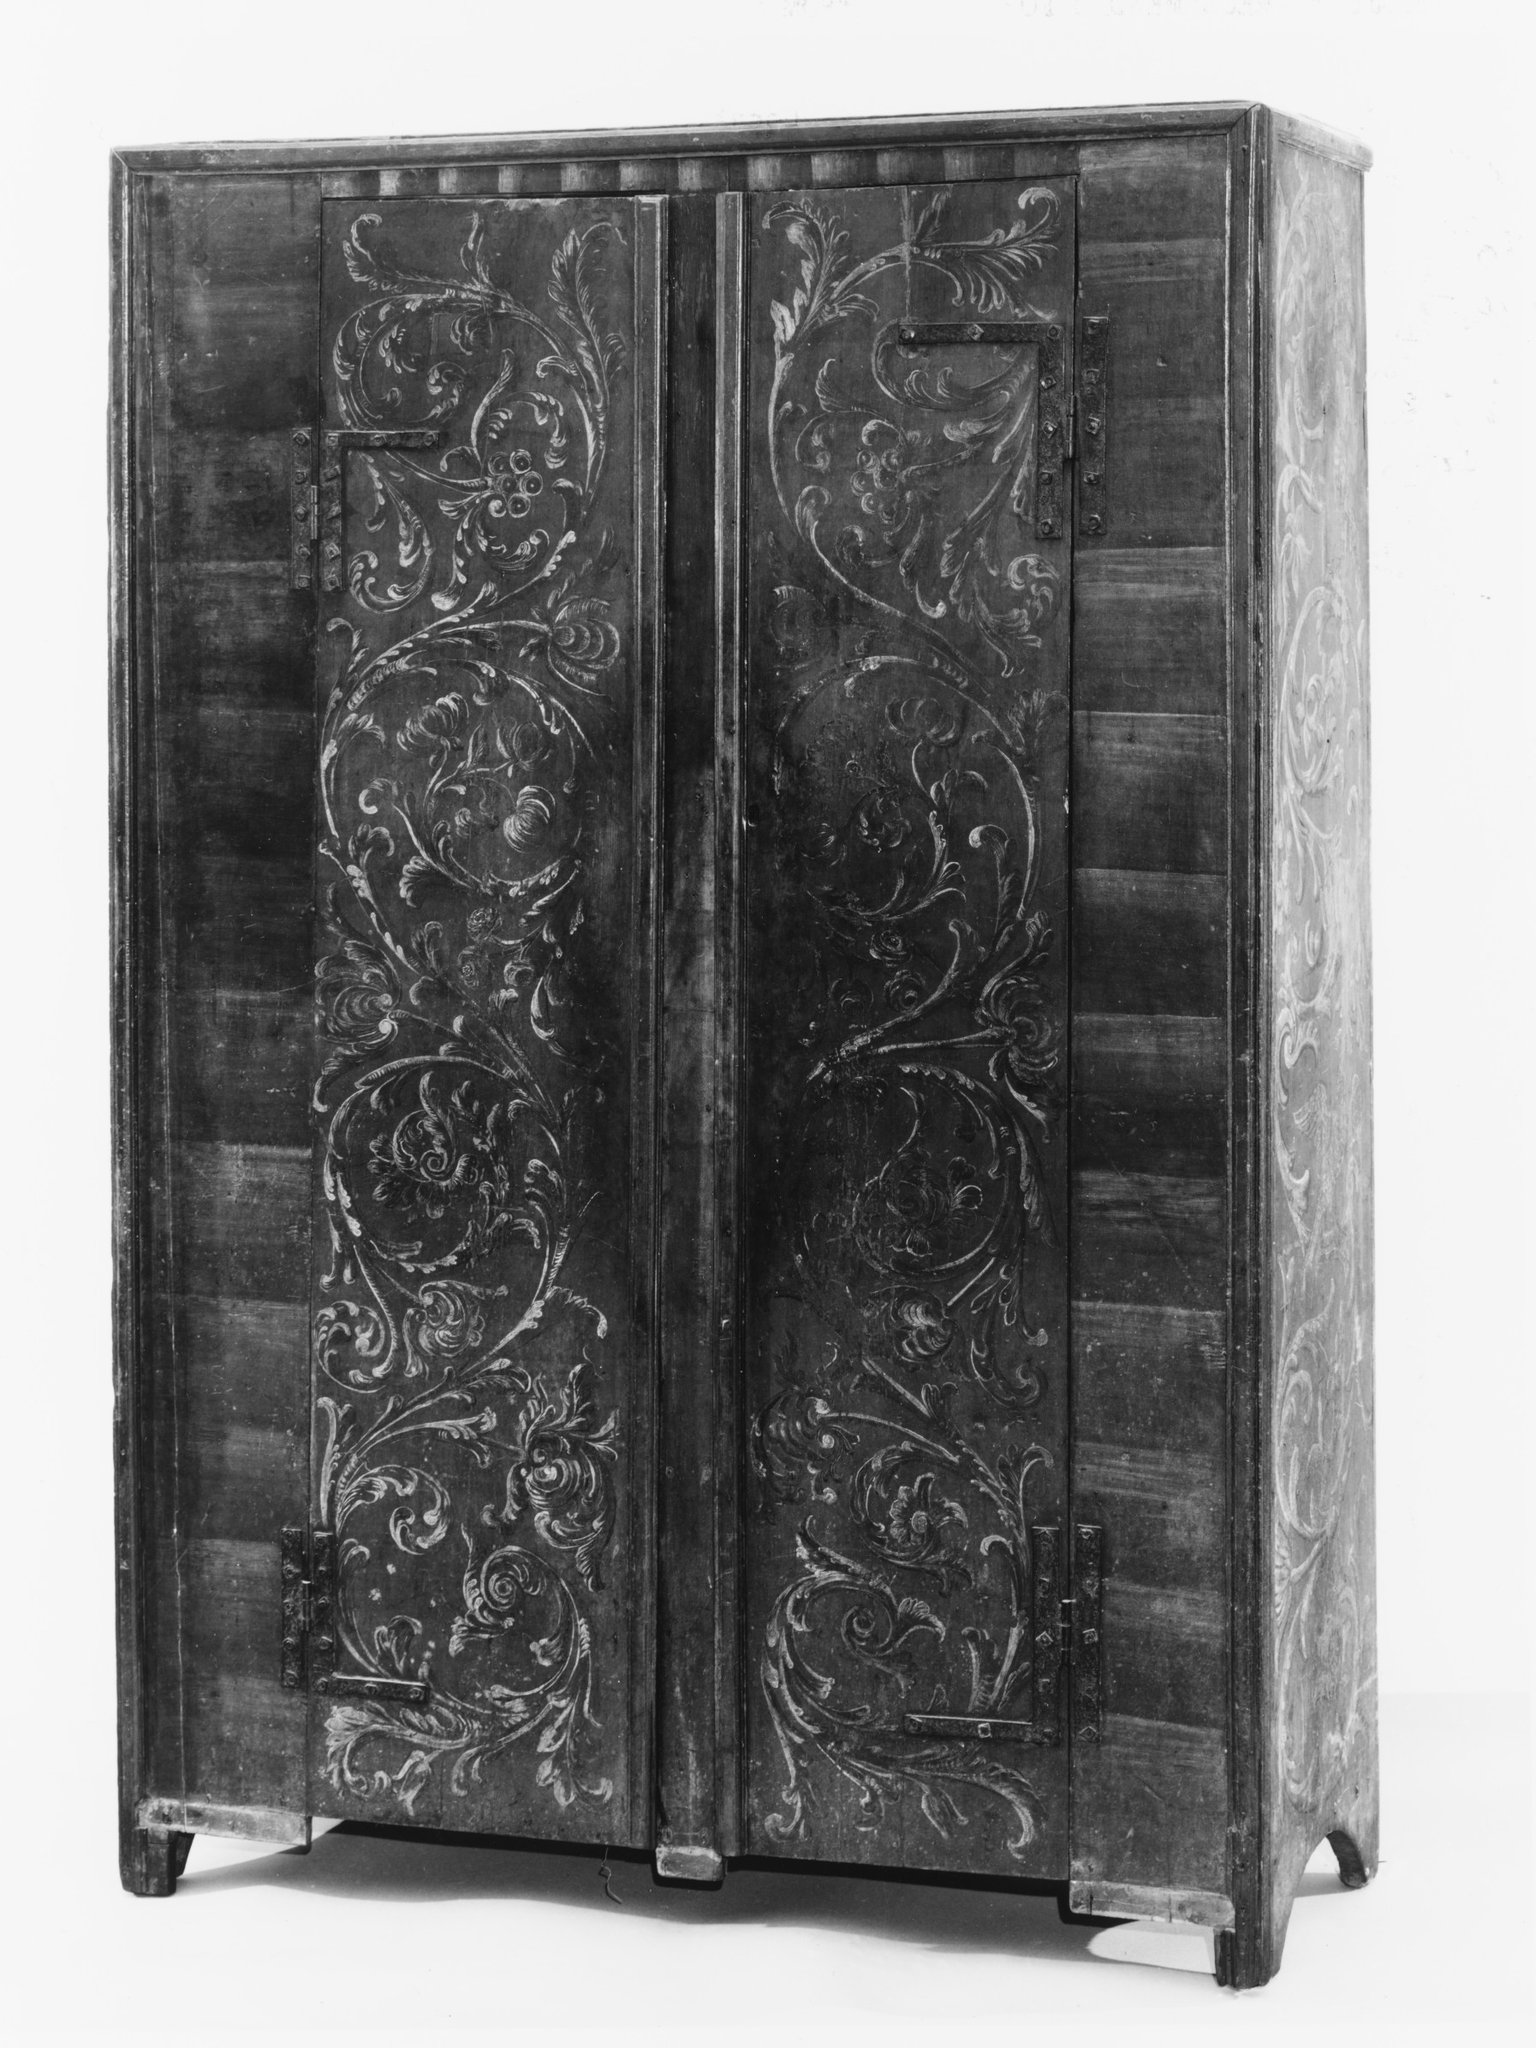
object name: cabinet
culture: american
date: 1700-1750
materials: wood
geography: united states